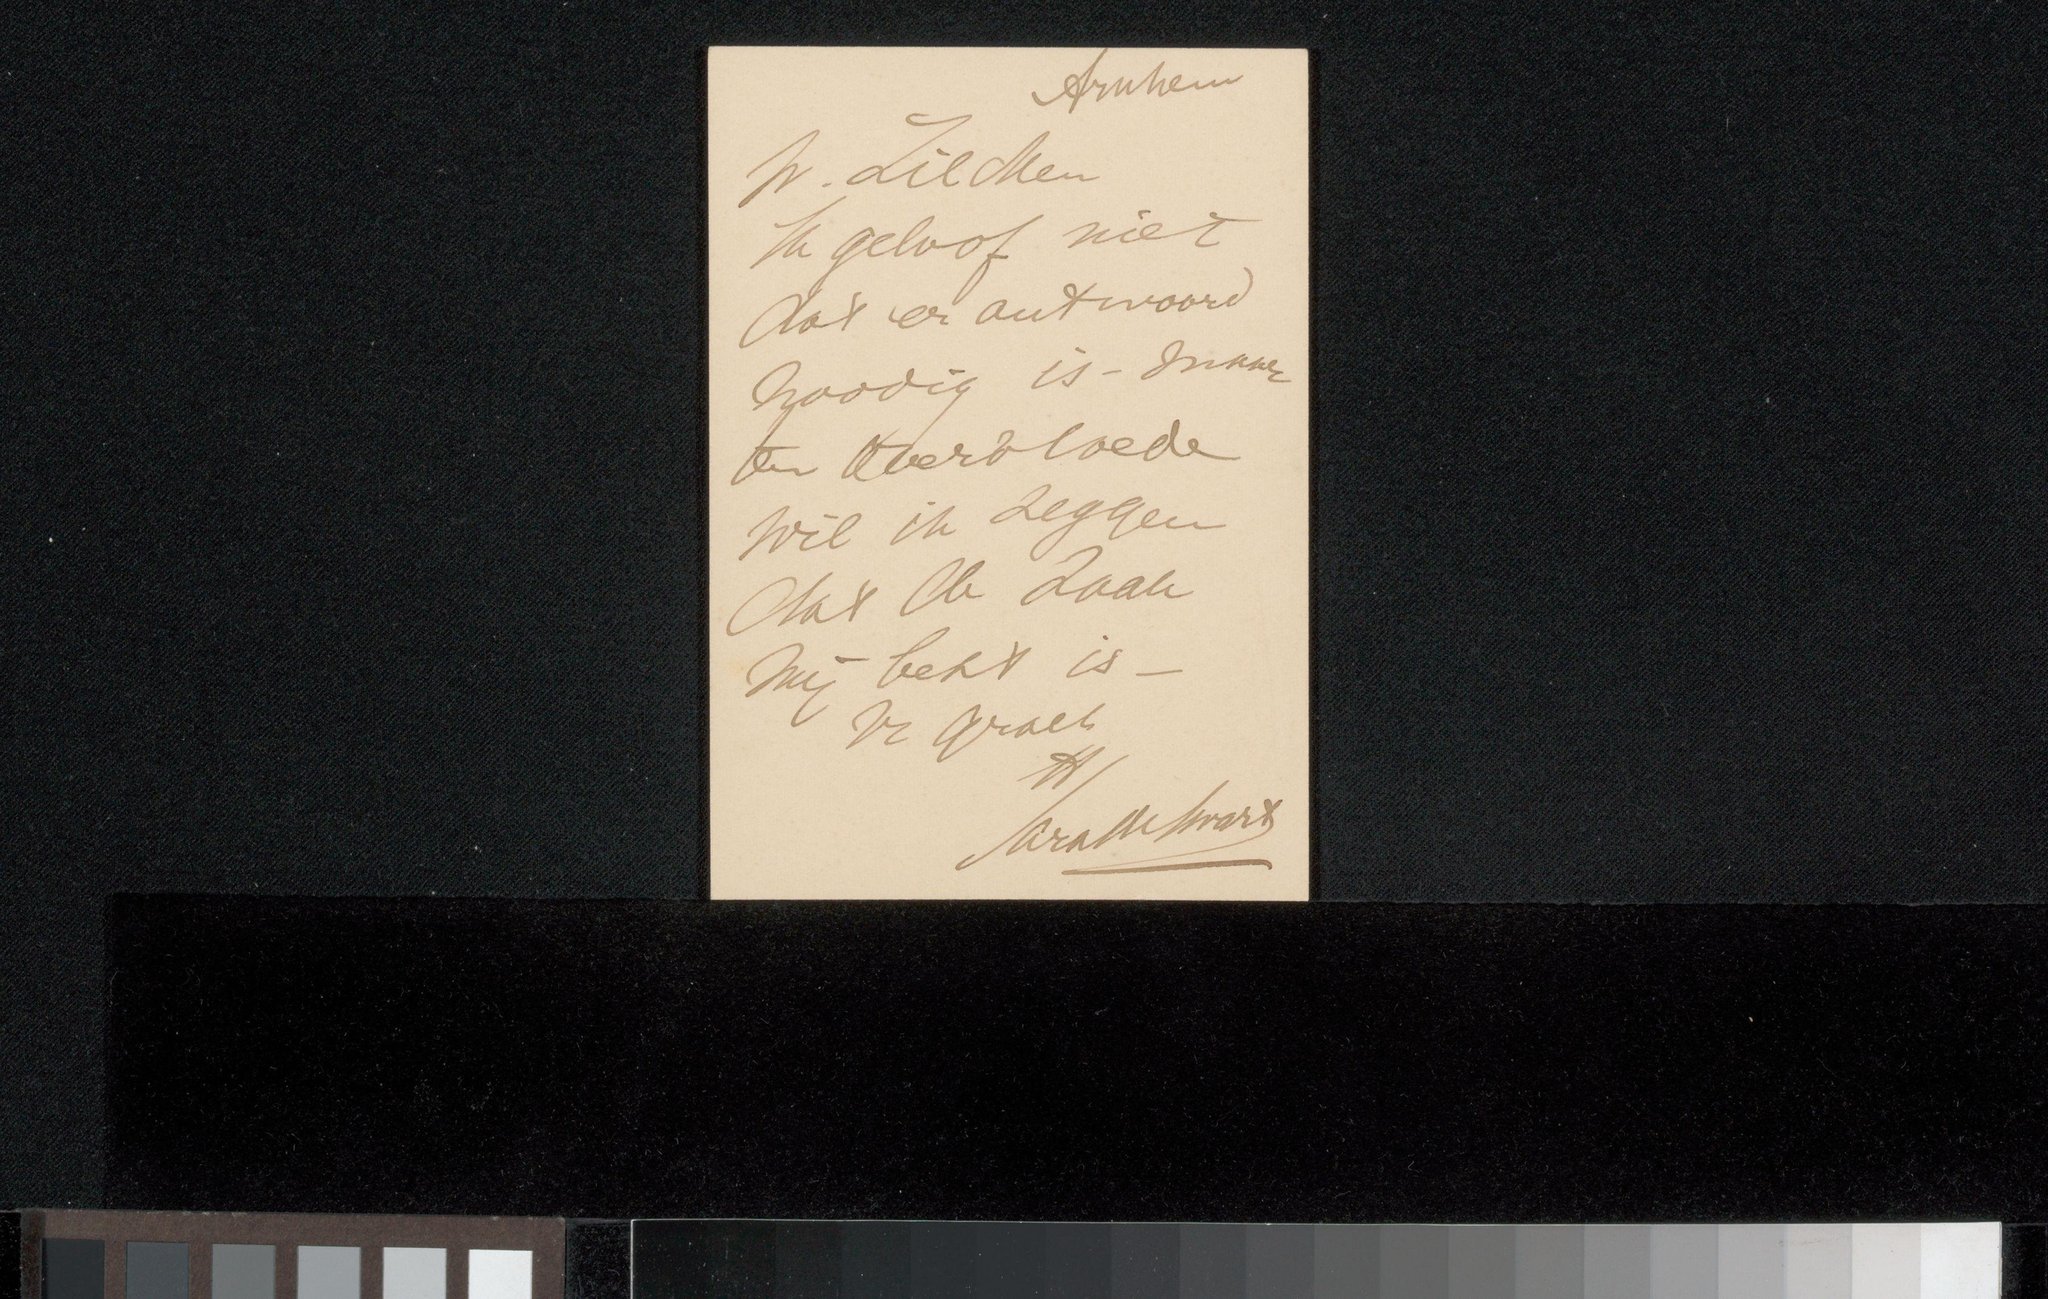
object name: letter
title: Brief aan Philip Zilcken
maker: saar de swart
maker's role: sculptor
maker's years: 1861-1951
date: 1871-1930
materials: cardboard, ink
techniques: pen, writing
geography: arnhem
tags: the hague, painter, draughtsman, philip zilcken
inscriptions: collector's mark: ‘RPK’